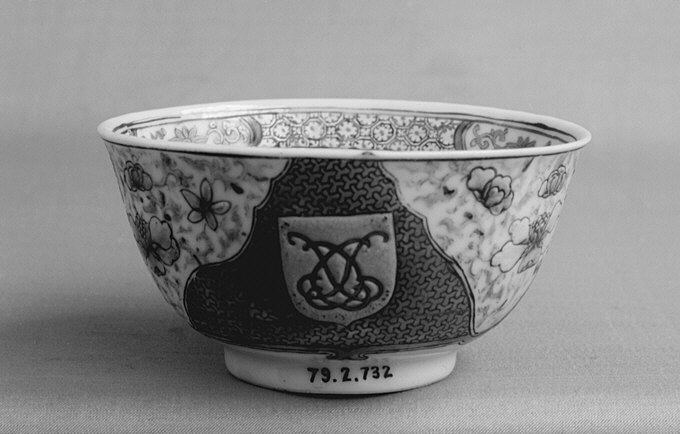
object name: teabowl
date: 1725-1730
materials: hard paste porcelain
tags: flowers